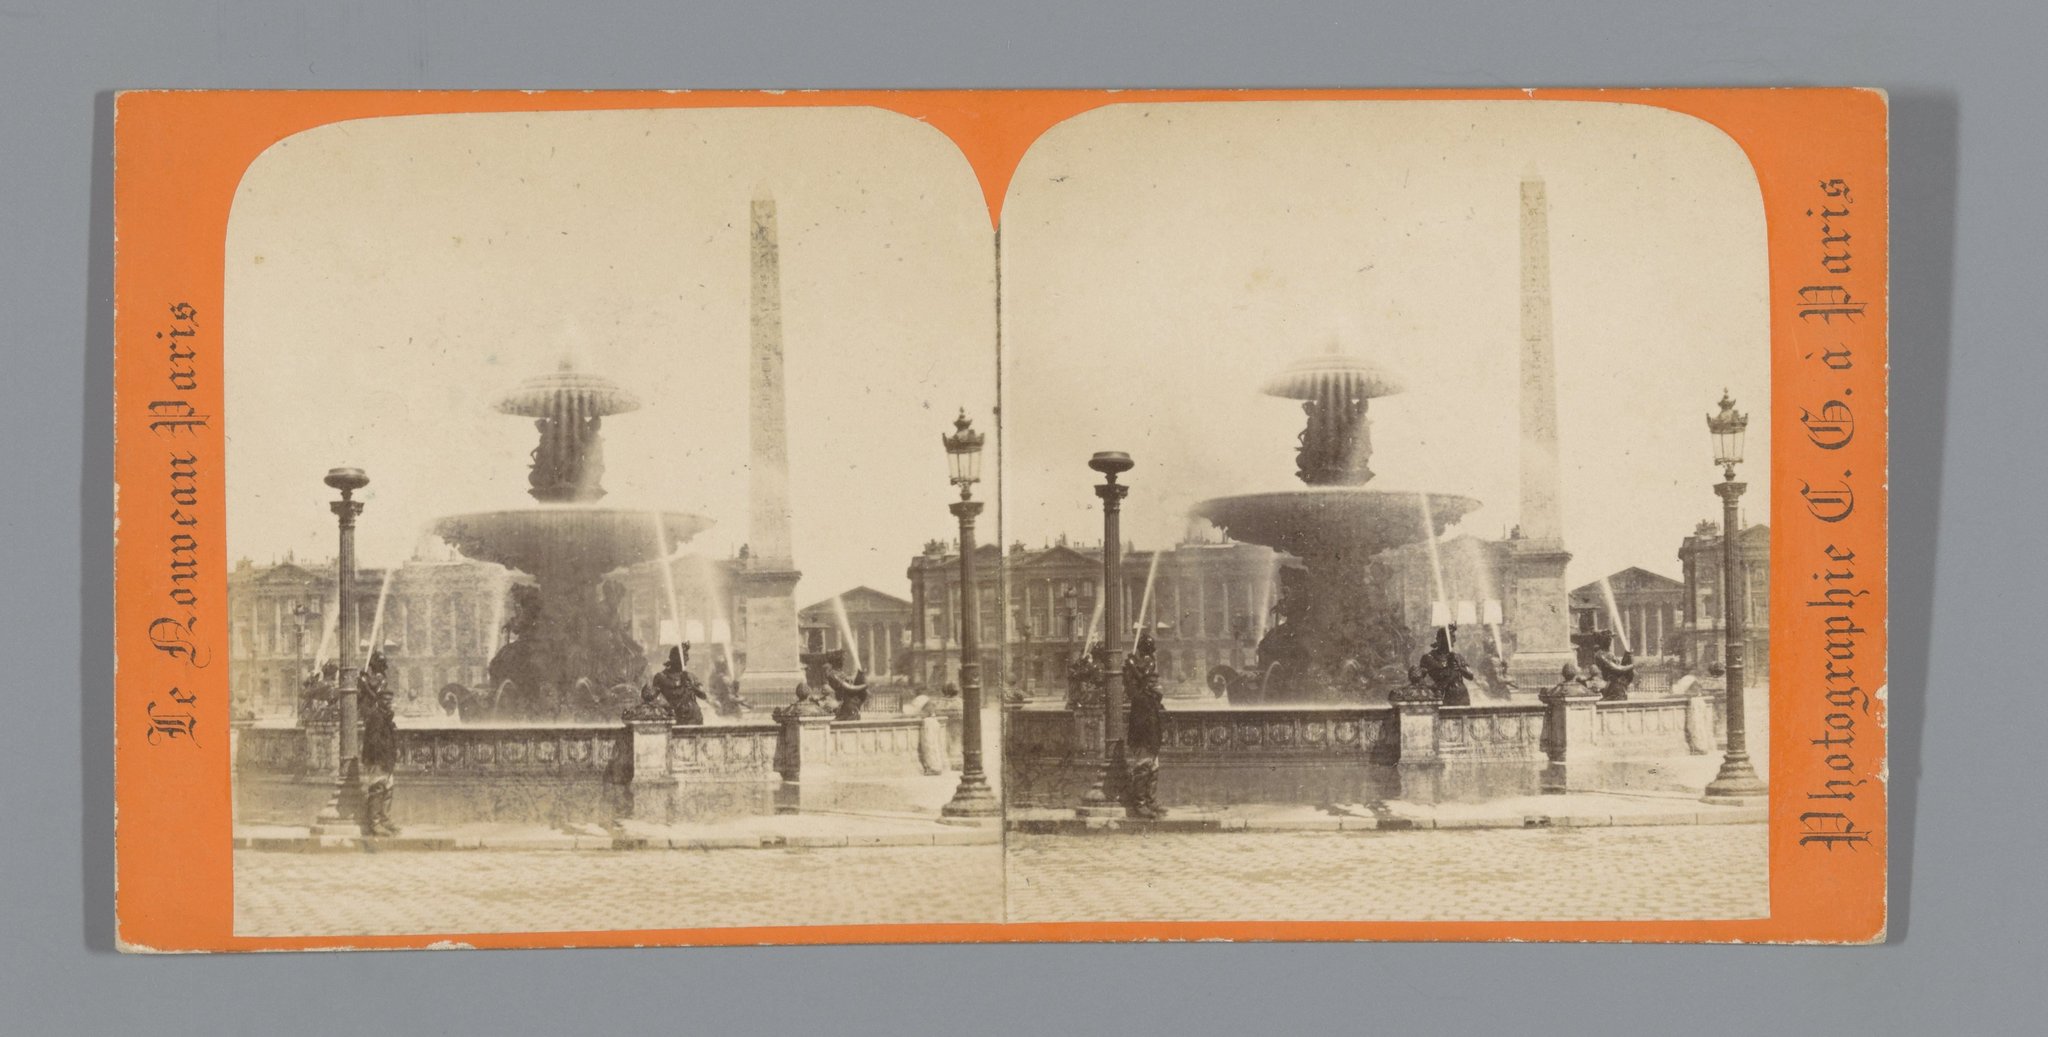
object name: stereograph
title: Le Nouveau Paris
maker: charles gérard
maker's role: fotograaf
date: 1860-1870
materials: cardboard, photographic support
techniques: albumen print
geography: place de la concorde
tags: square, place, circus, etc., obelisk, needle, ornamental fountain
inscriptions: inscription: ‘Place de la concorde’, inscription: ‘Photographie C. G. à Paris.’